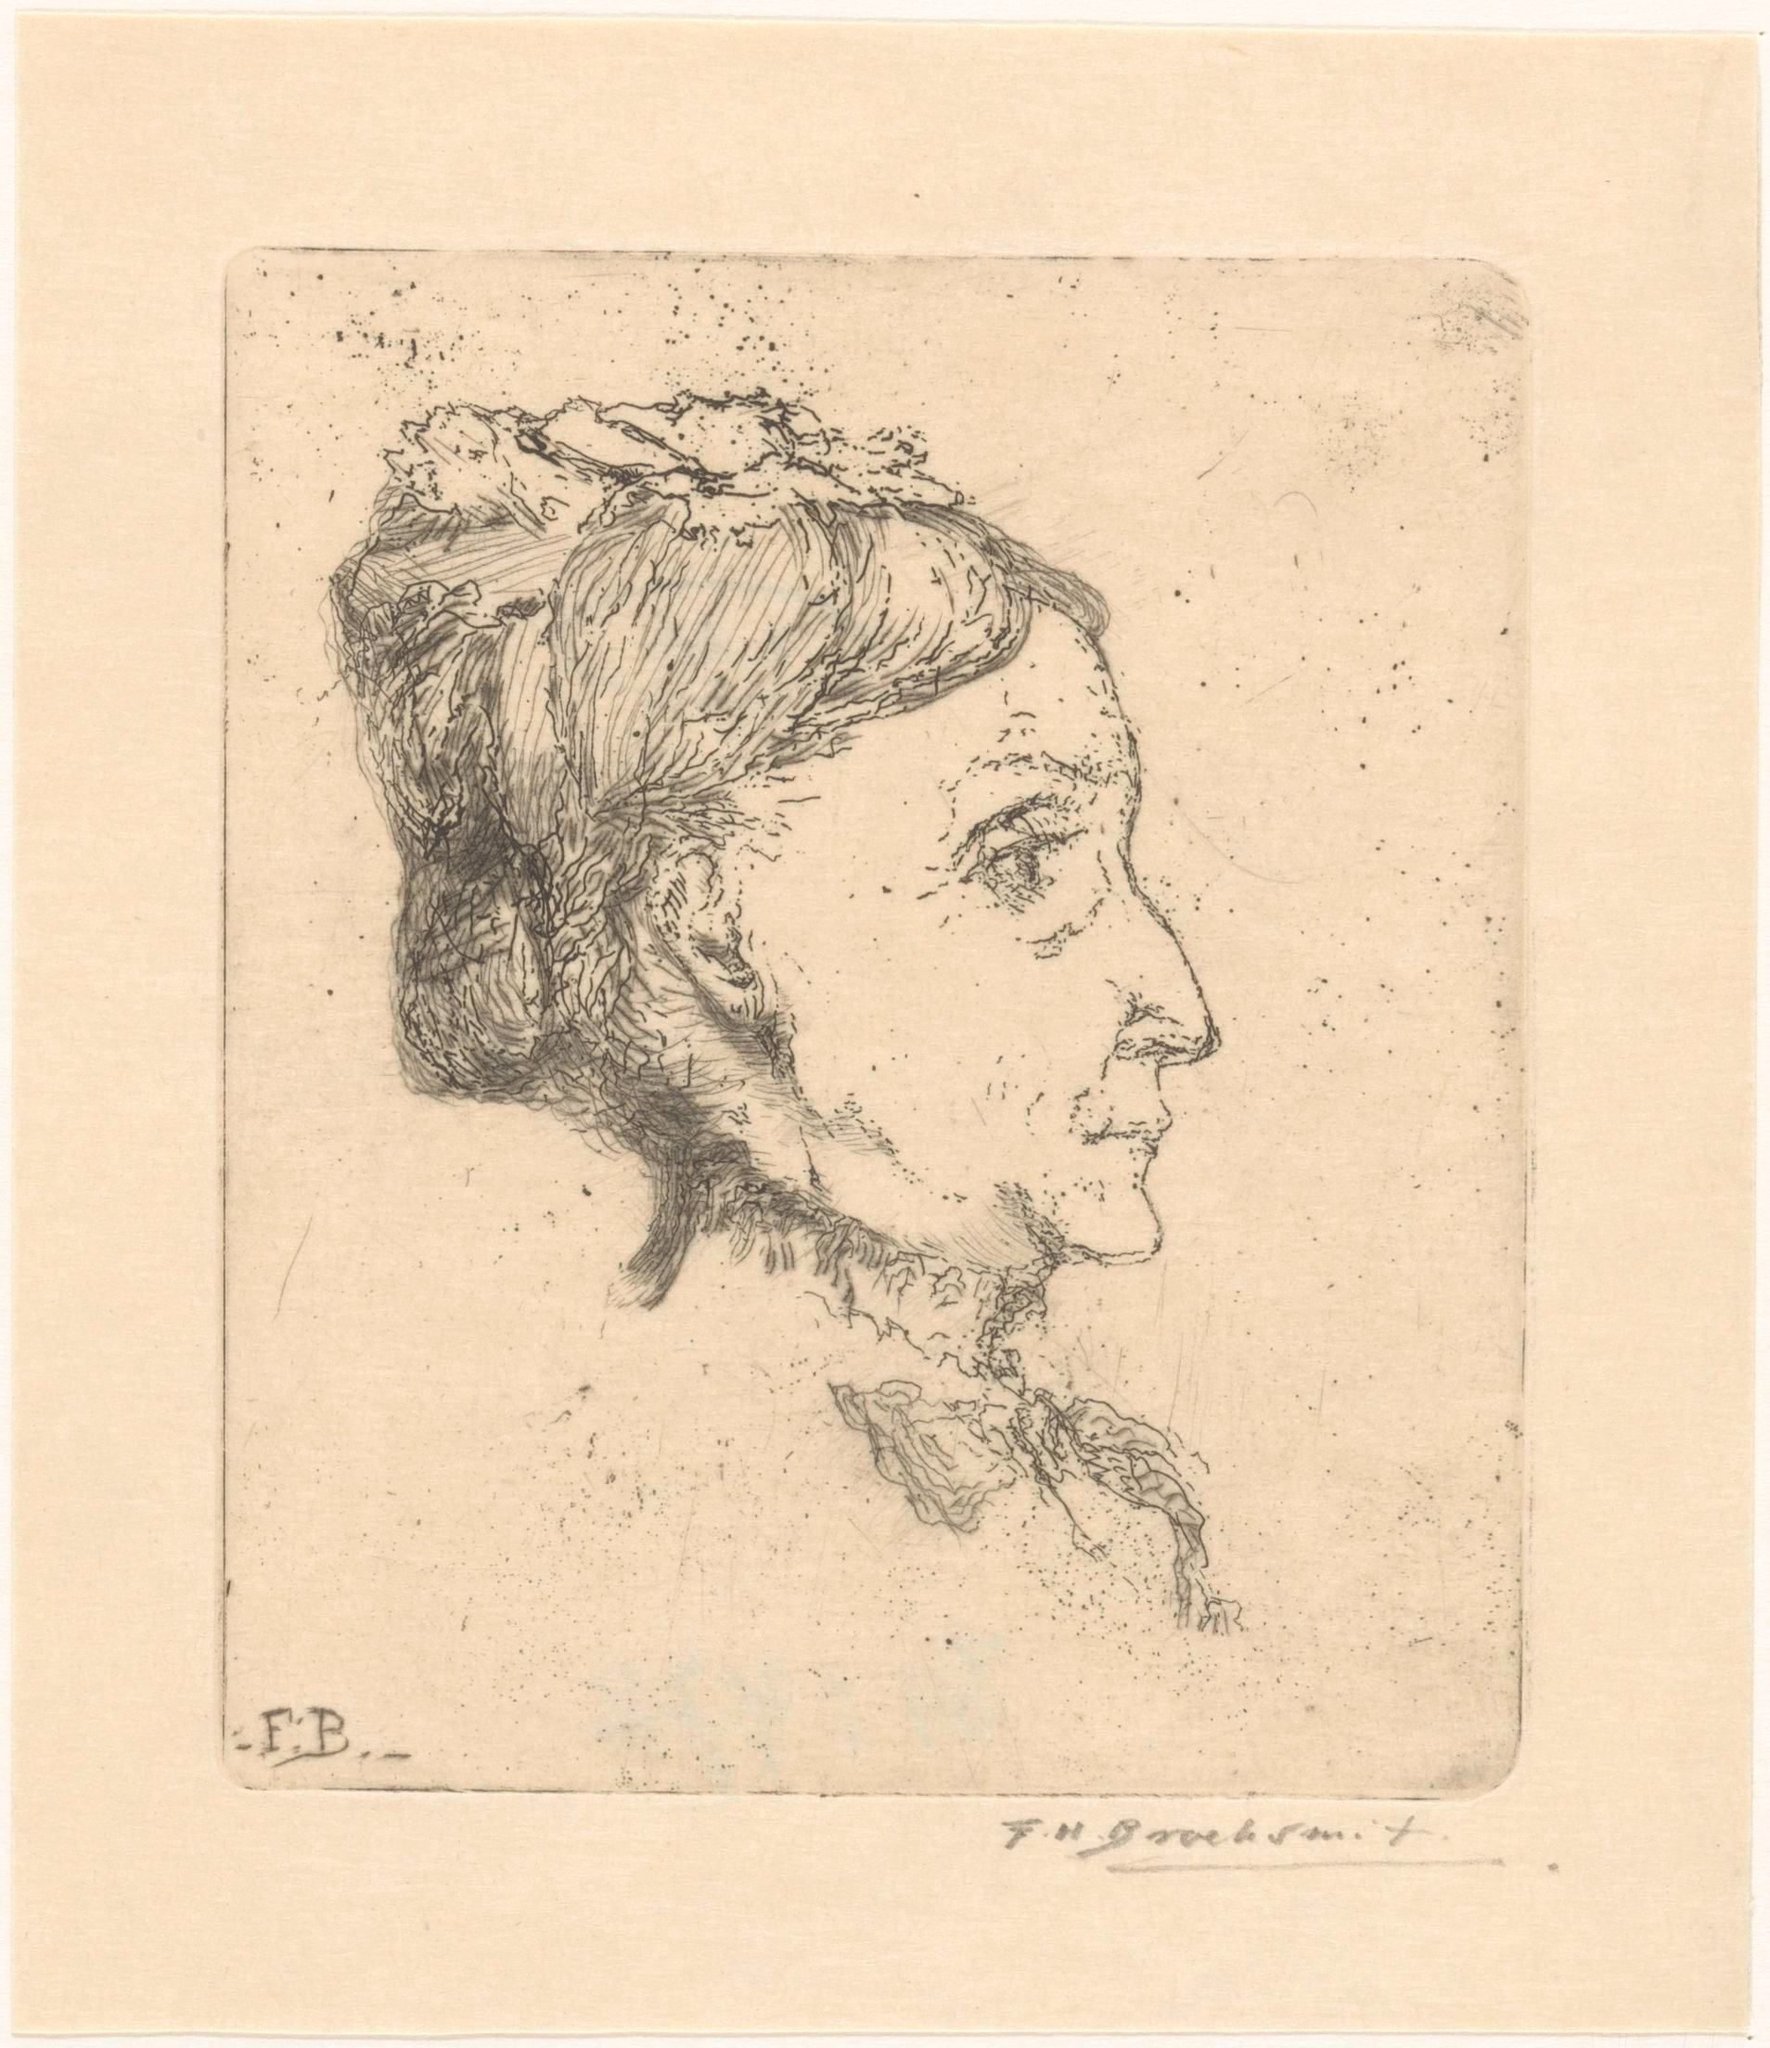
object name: print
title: Portret van een onbekende vrouw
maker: frederika henriëtte broeksmit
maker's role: draughtsman, print maker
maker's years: 1875-1945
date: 1885-1931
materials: paper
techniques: etching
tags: anonymous historical person portrayed - bb - woman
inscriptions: collector's mark: Lugt 2228